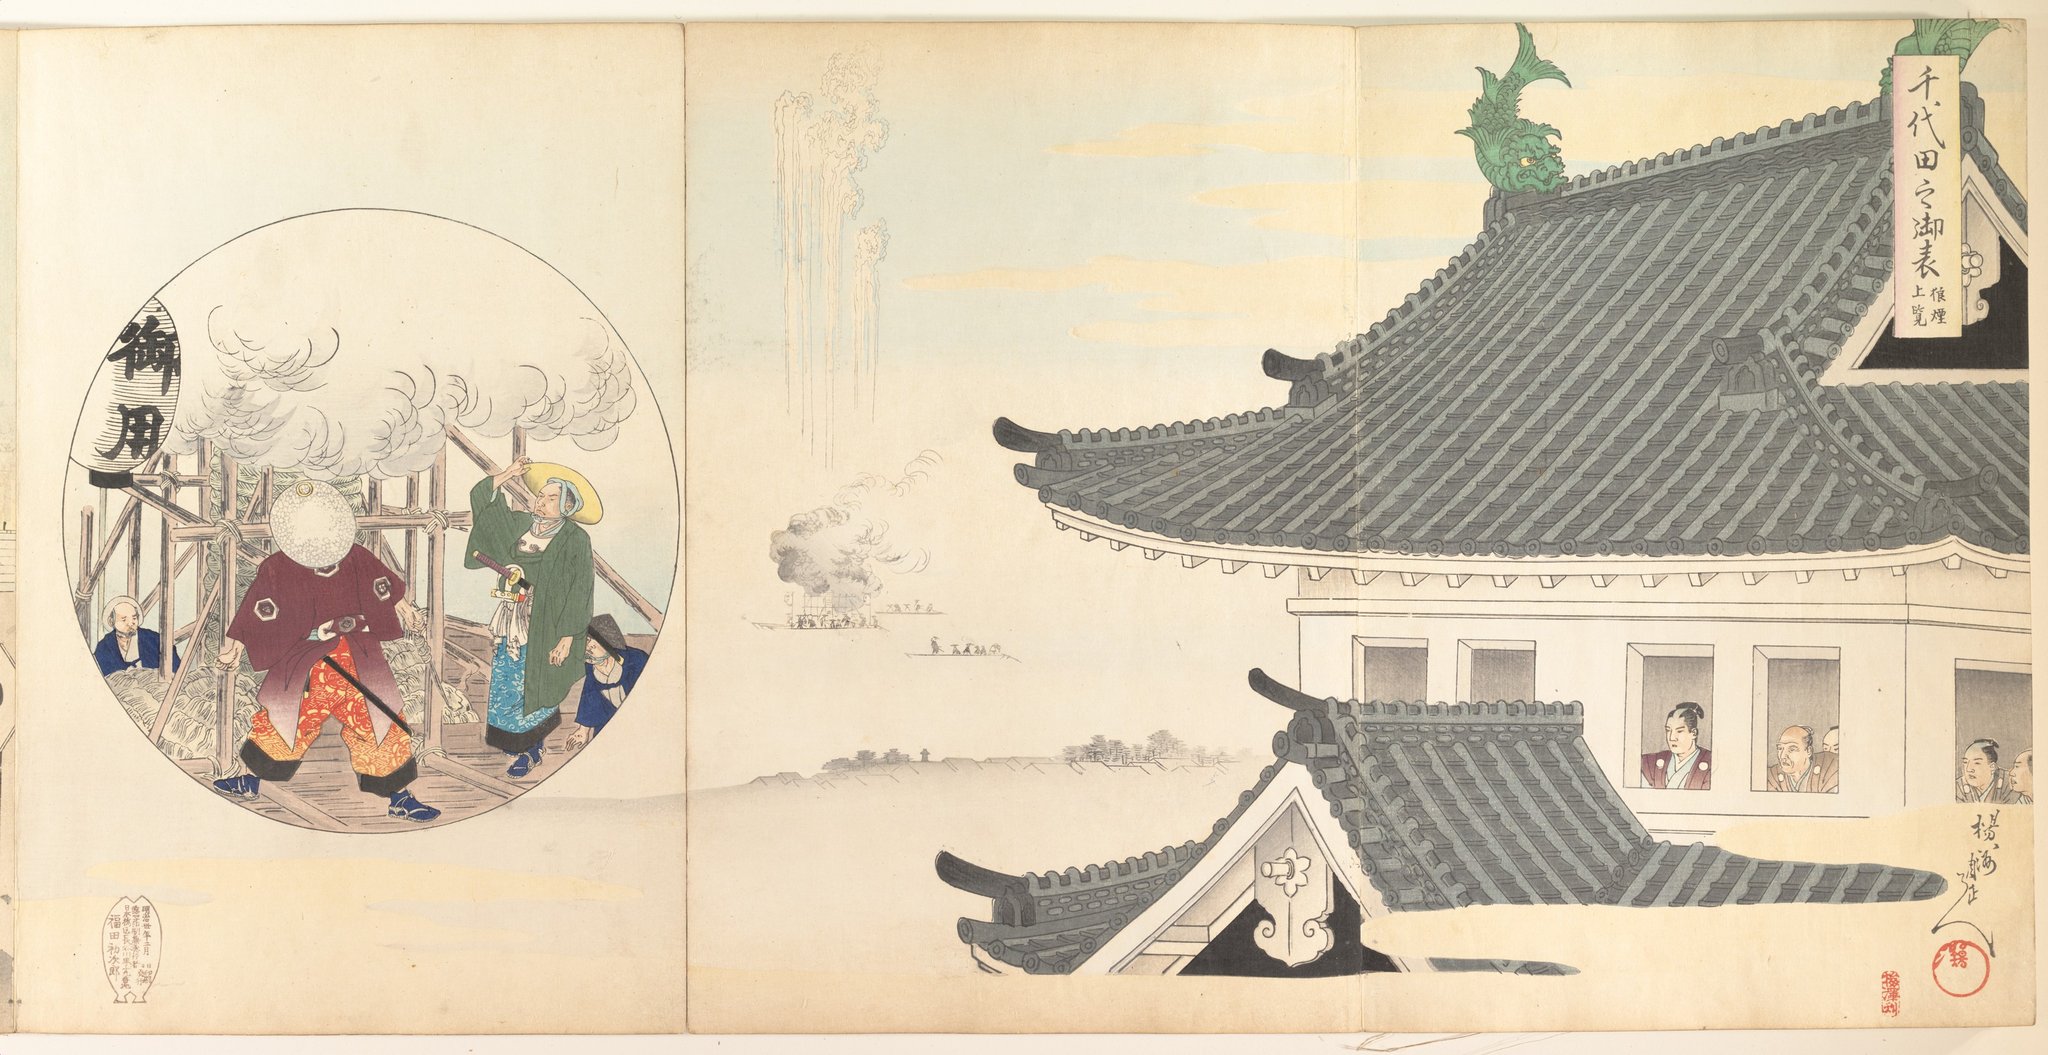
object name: print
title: Chiyoda Castle (Album of Men)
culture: japanese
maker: yōshū (hashimoto) chikanobu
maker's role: artist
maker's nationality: japanese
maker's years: 1838-1912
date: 1897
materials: ink, paper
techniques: woodblock print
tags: castles,men